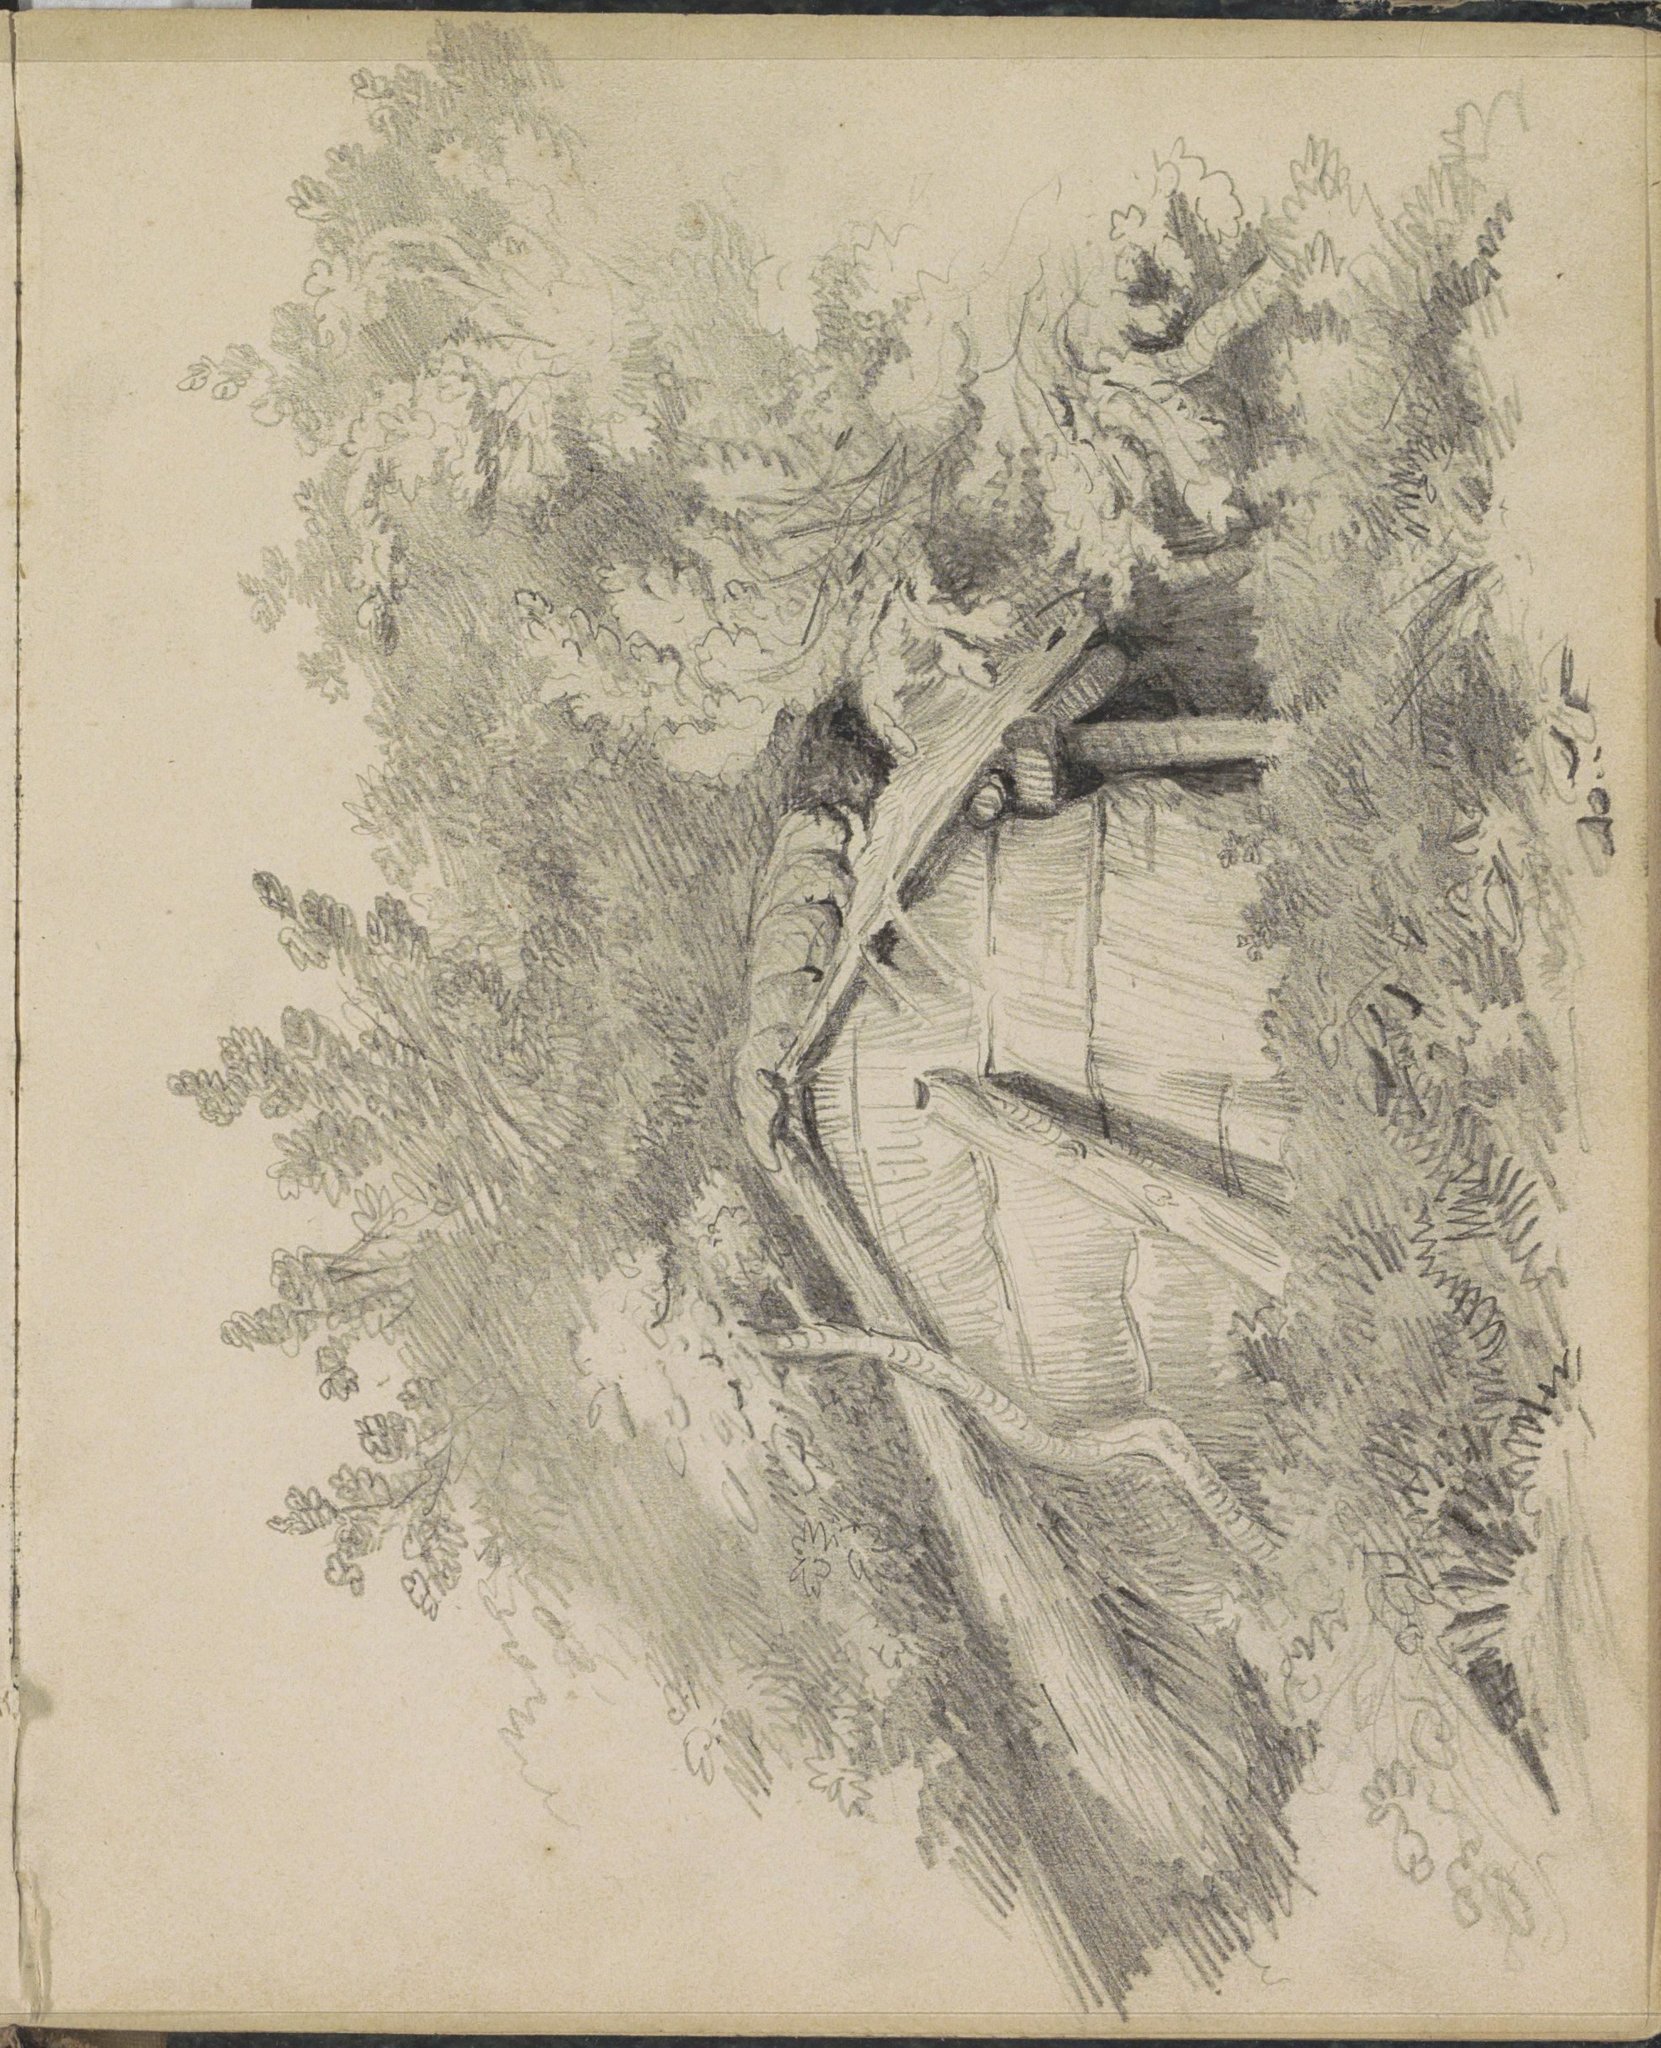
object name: sketchbook leaf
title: Rieten hut tussen de bomen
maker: johannes tavenraat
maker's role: draughtsman, painter, print maker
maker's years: 1809-1881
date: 1841-1853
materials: paper, pencil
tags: trees, hut, cabin, lodge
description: Blad 47 recto uit een schetsboek met 87 bladen.